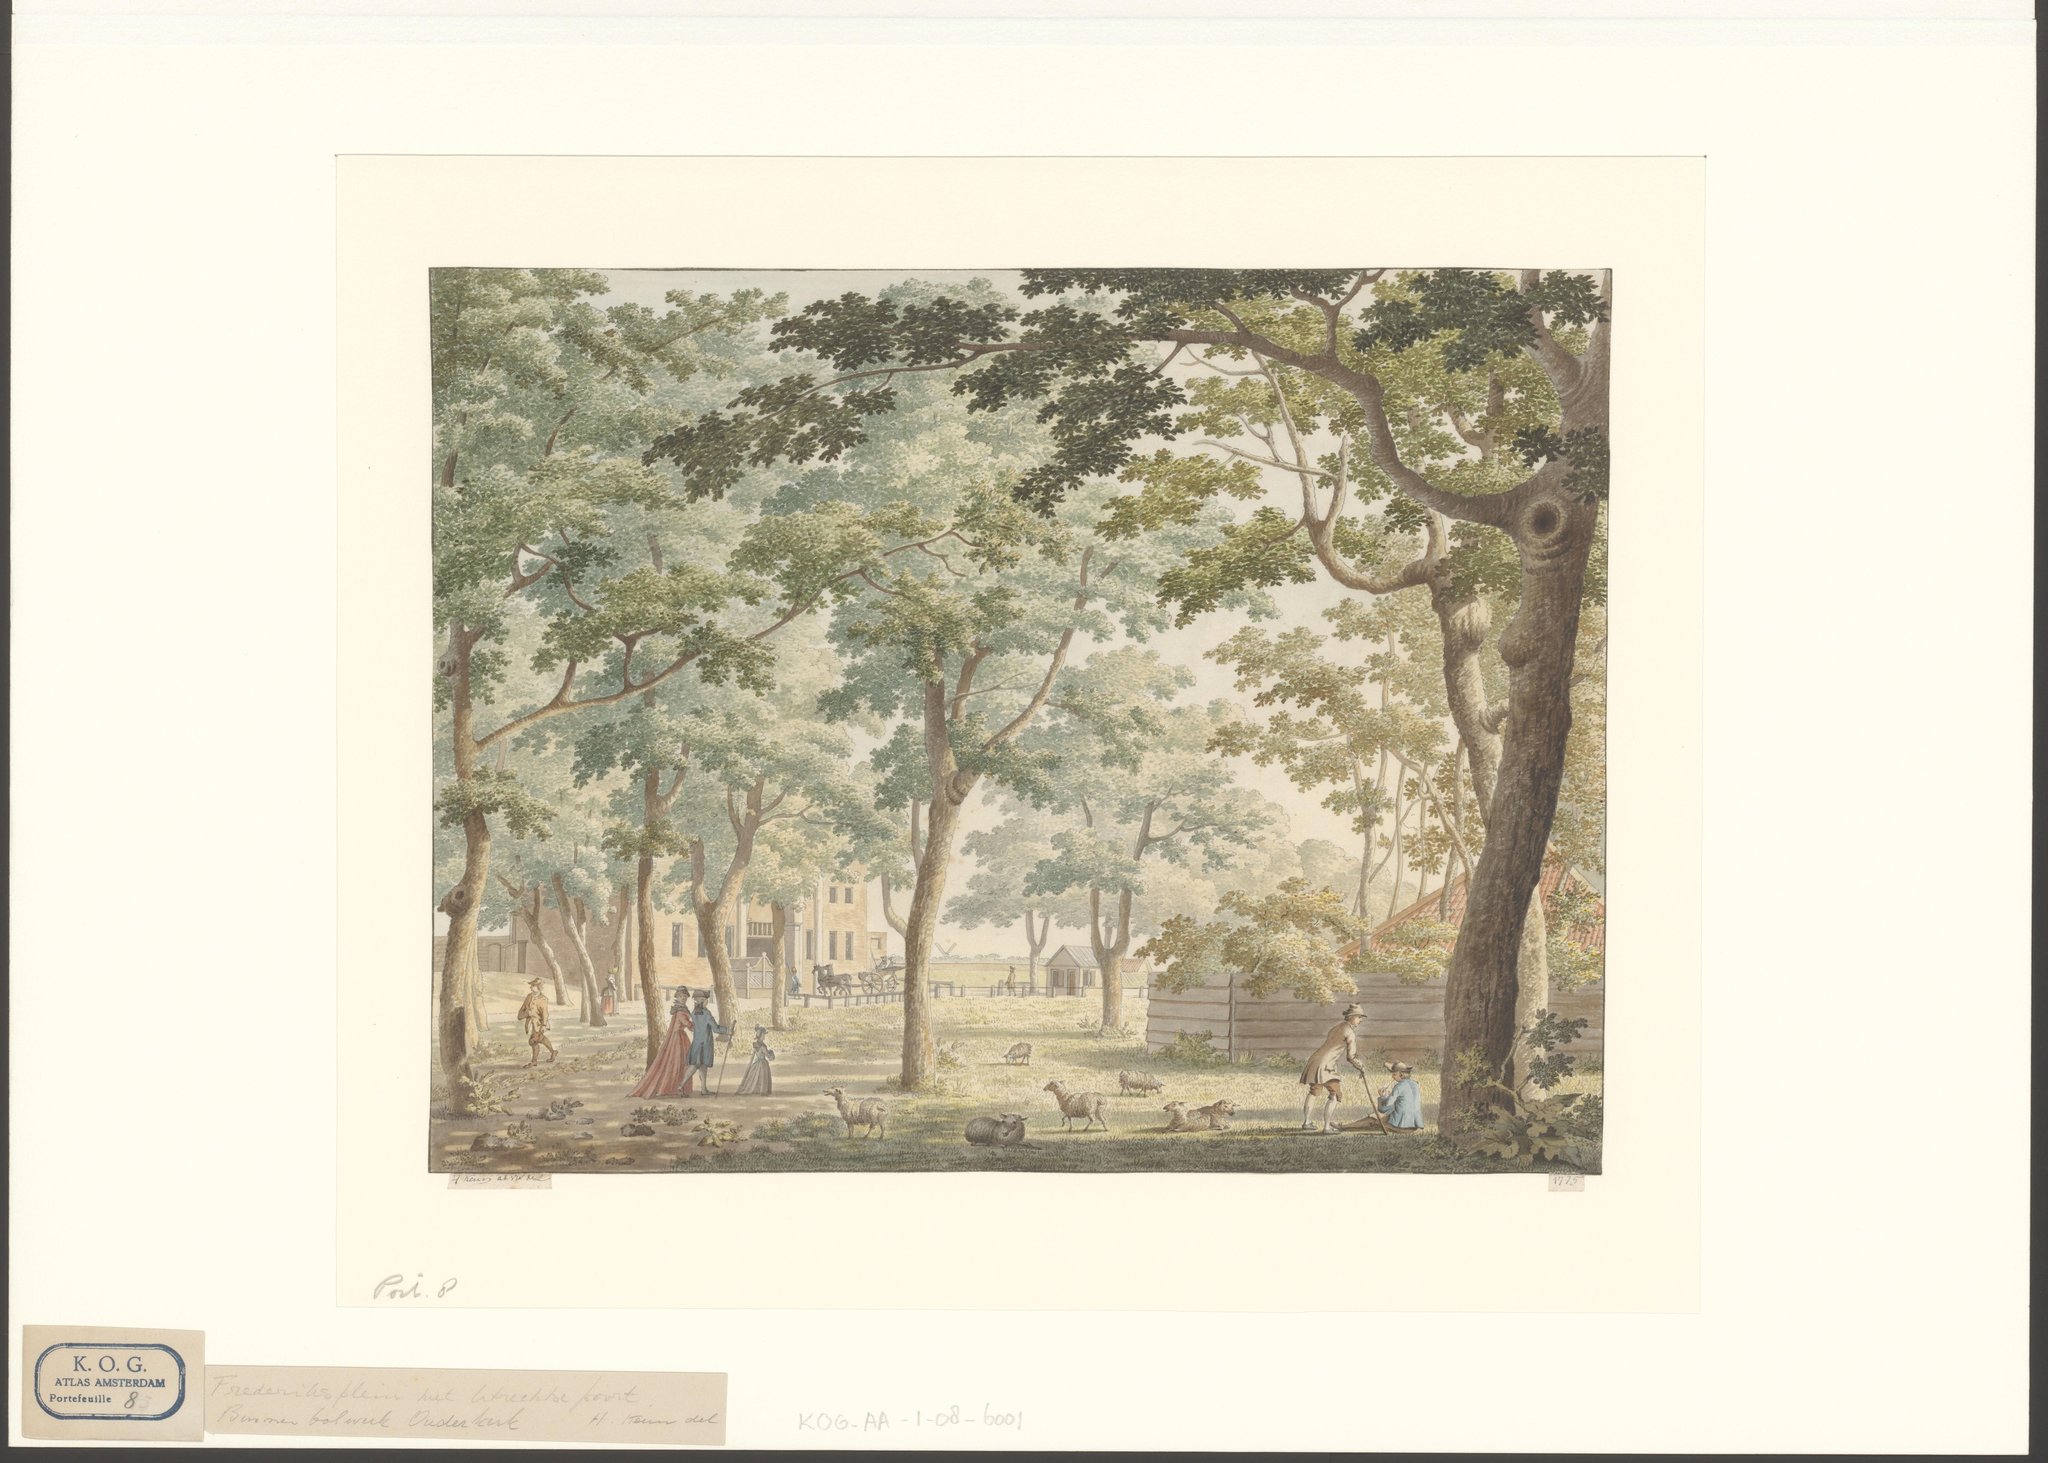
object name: drawing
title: Gezicht op het Frederiksplein met de Utrechtsepoort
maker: hendrik keun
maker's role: painter, print maker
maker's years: 1738-1787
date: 1775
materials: ink, paper, pencil, watercolor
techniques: brush, pen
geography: amsterdam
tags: city-view in general; 'veduta', city-gate, public gardens, park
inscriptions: inscription: ‘Frederiksplein met Utrechtsepoort. / Binnen bolwerk Ouderkerk / H. Keun del’, inscription: ‘Port. 8’, signature and date: ‘H Keun adviv del / 1775’, collector's mark: ‘8’ Lugt 1641b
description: Onderwerpsrubriek binnen de Atlas Amsterdam: Egelantiersdwarsstraat, Egelantiersgracht, Elandsgracht, Engelschesteeg, Foeliedwarsstraat, Frederiksplein, Funen.